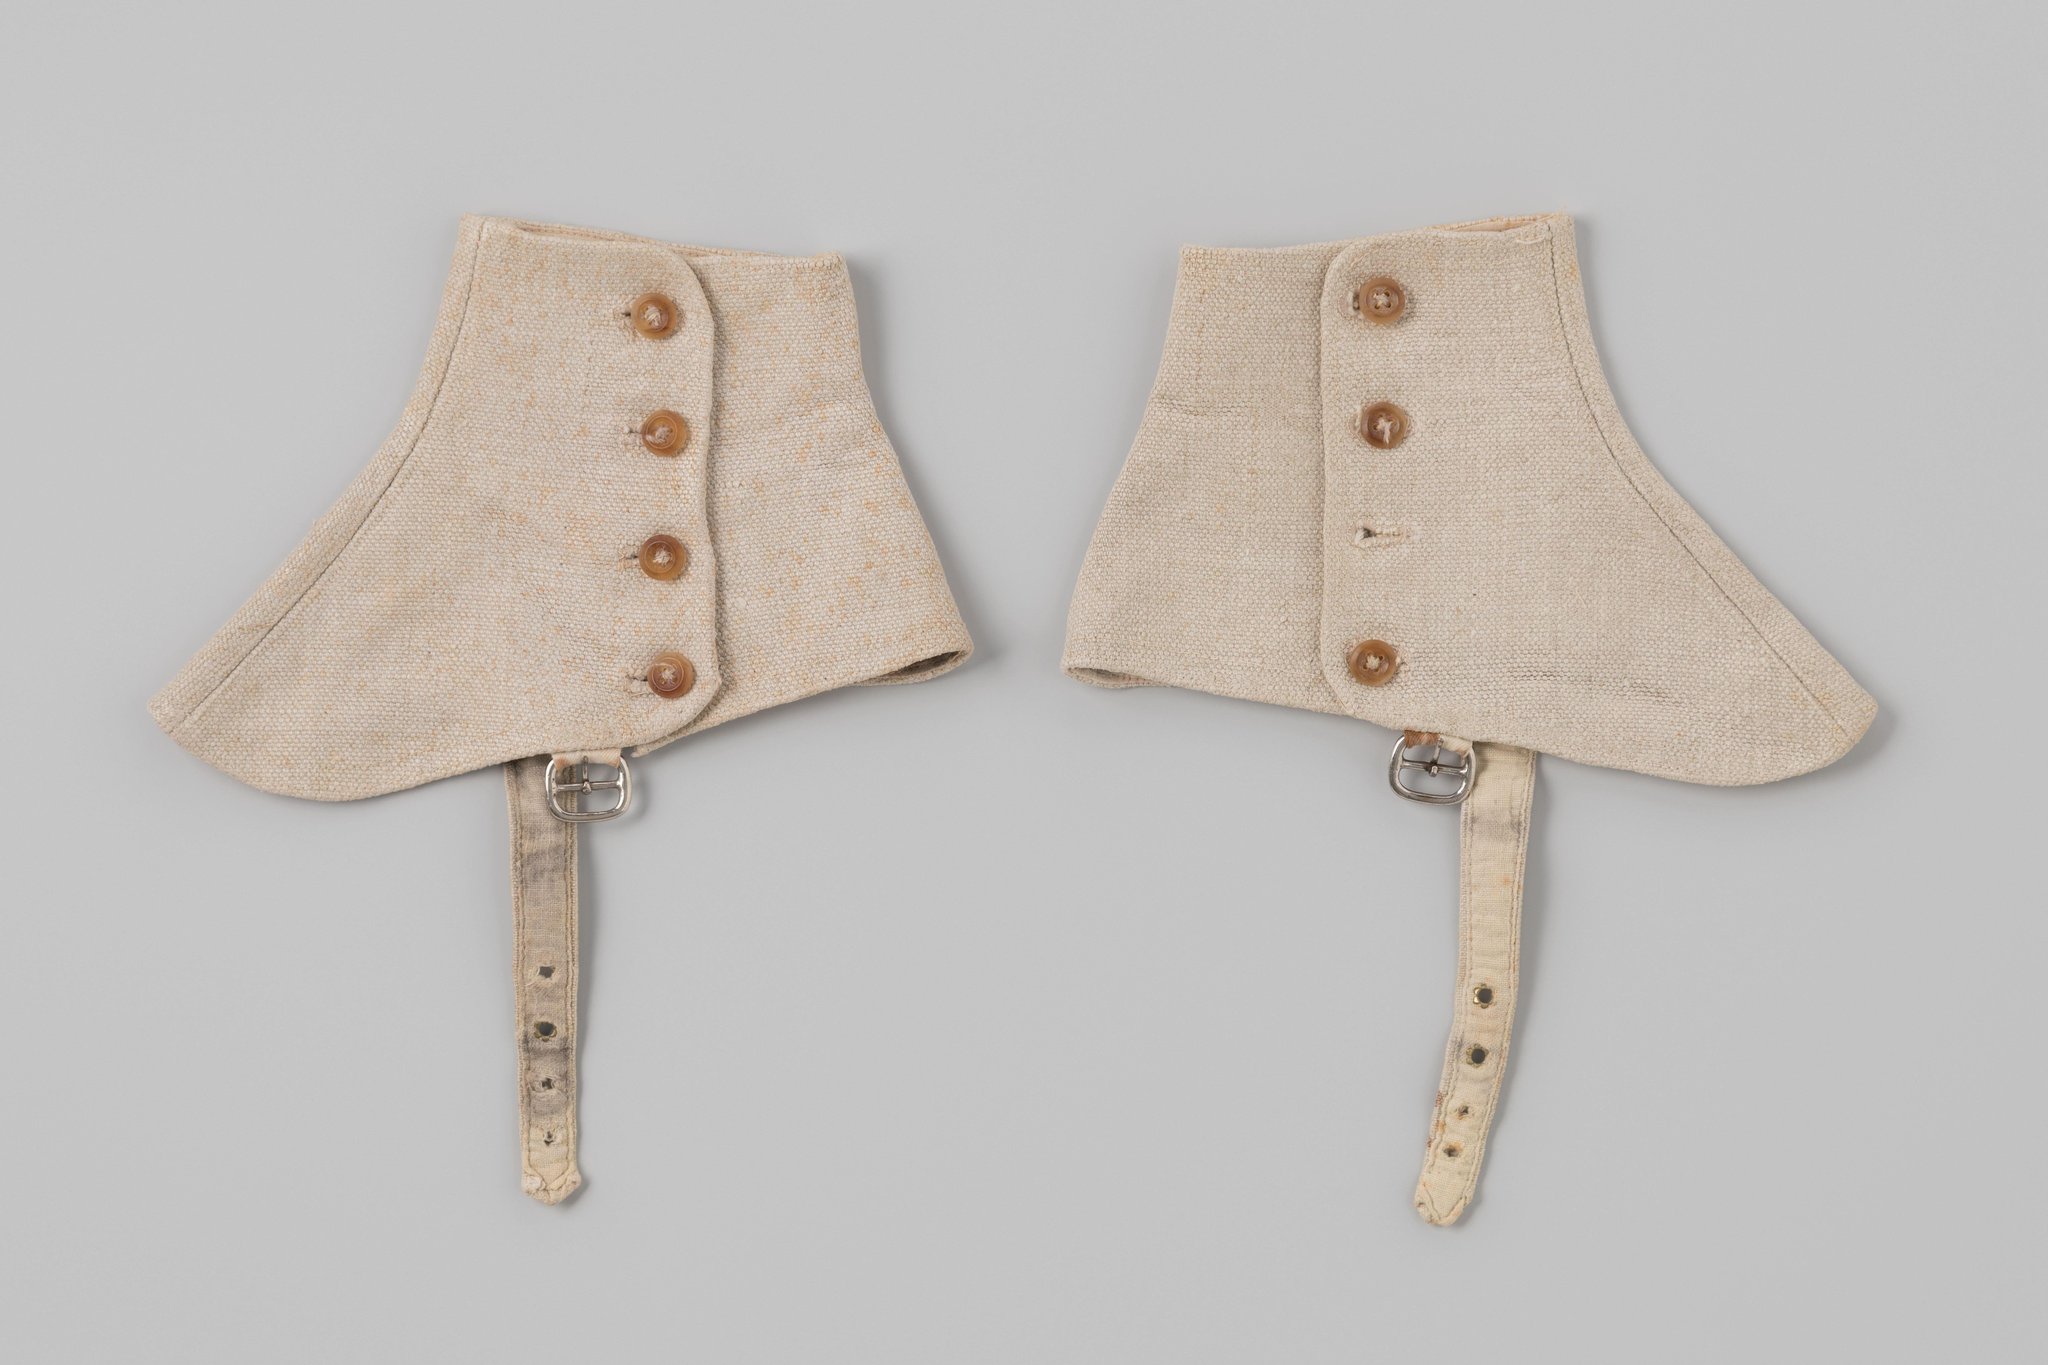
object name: spat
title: Slobkous van grof ecrukleurige linnenkatoen met vier bruine knopen en een linnen riem met metalen gesp onder de voet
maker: Anonymous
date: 1900-1930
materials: cotton, metal, plastic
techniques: weave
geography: netherlands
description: Slobkous van grof ecrukleurige linnenkatoen met vier bruine knopen en een linnen riem met zilverkleurige metalen gesp onder de voet. Gevoerd met fijne ecrukleurige linnenkatoen.